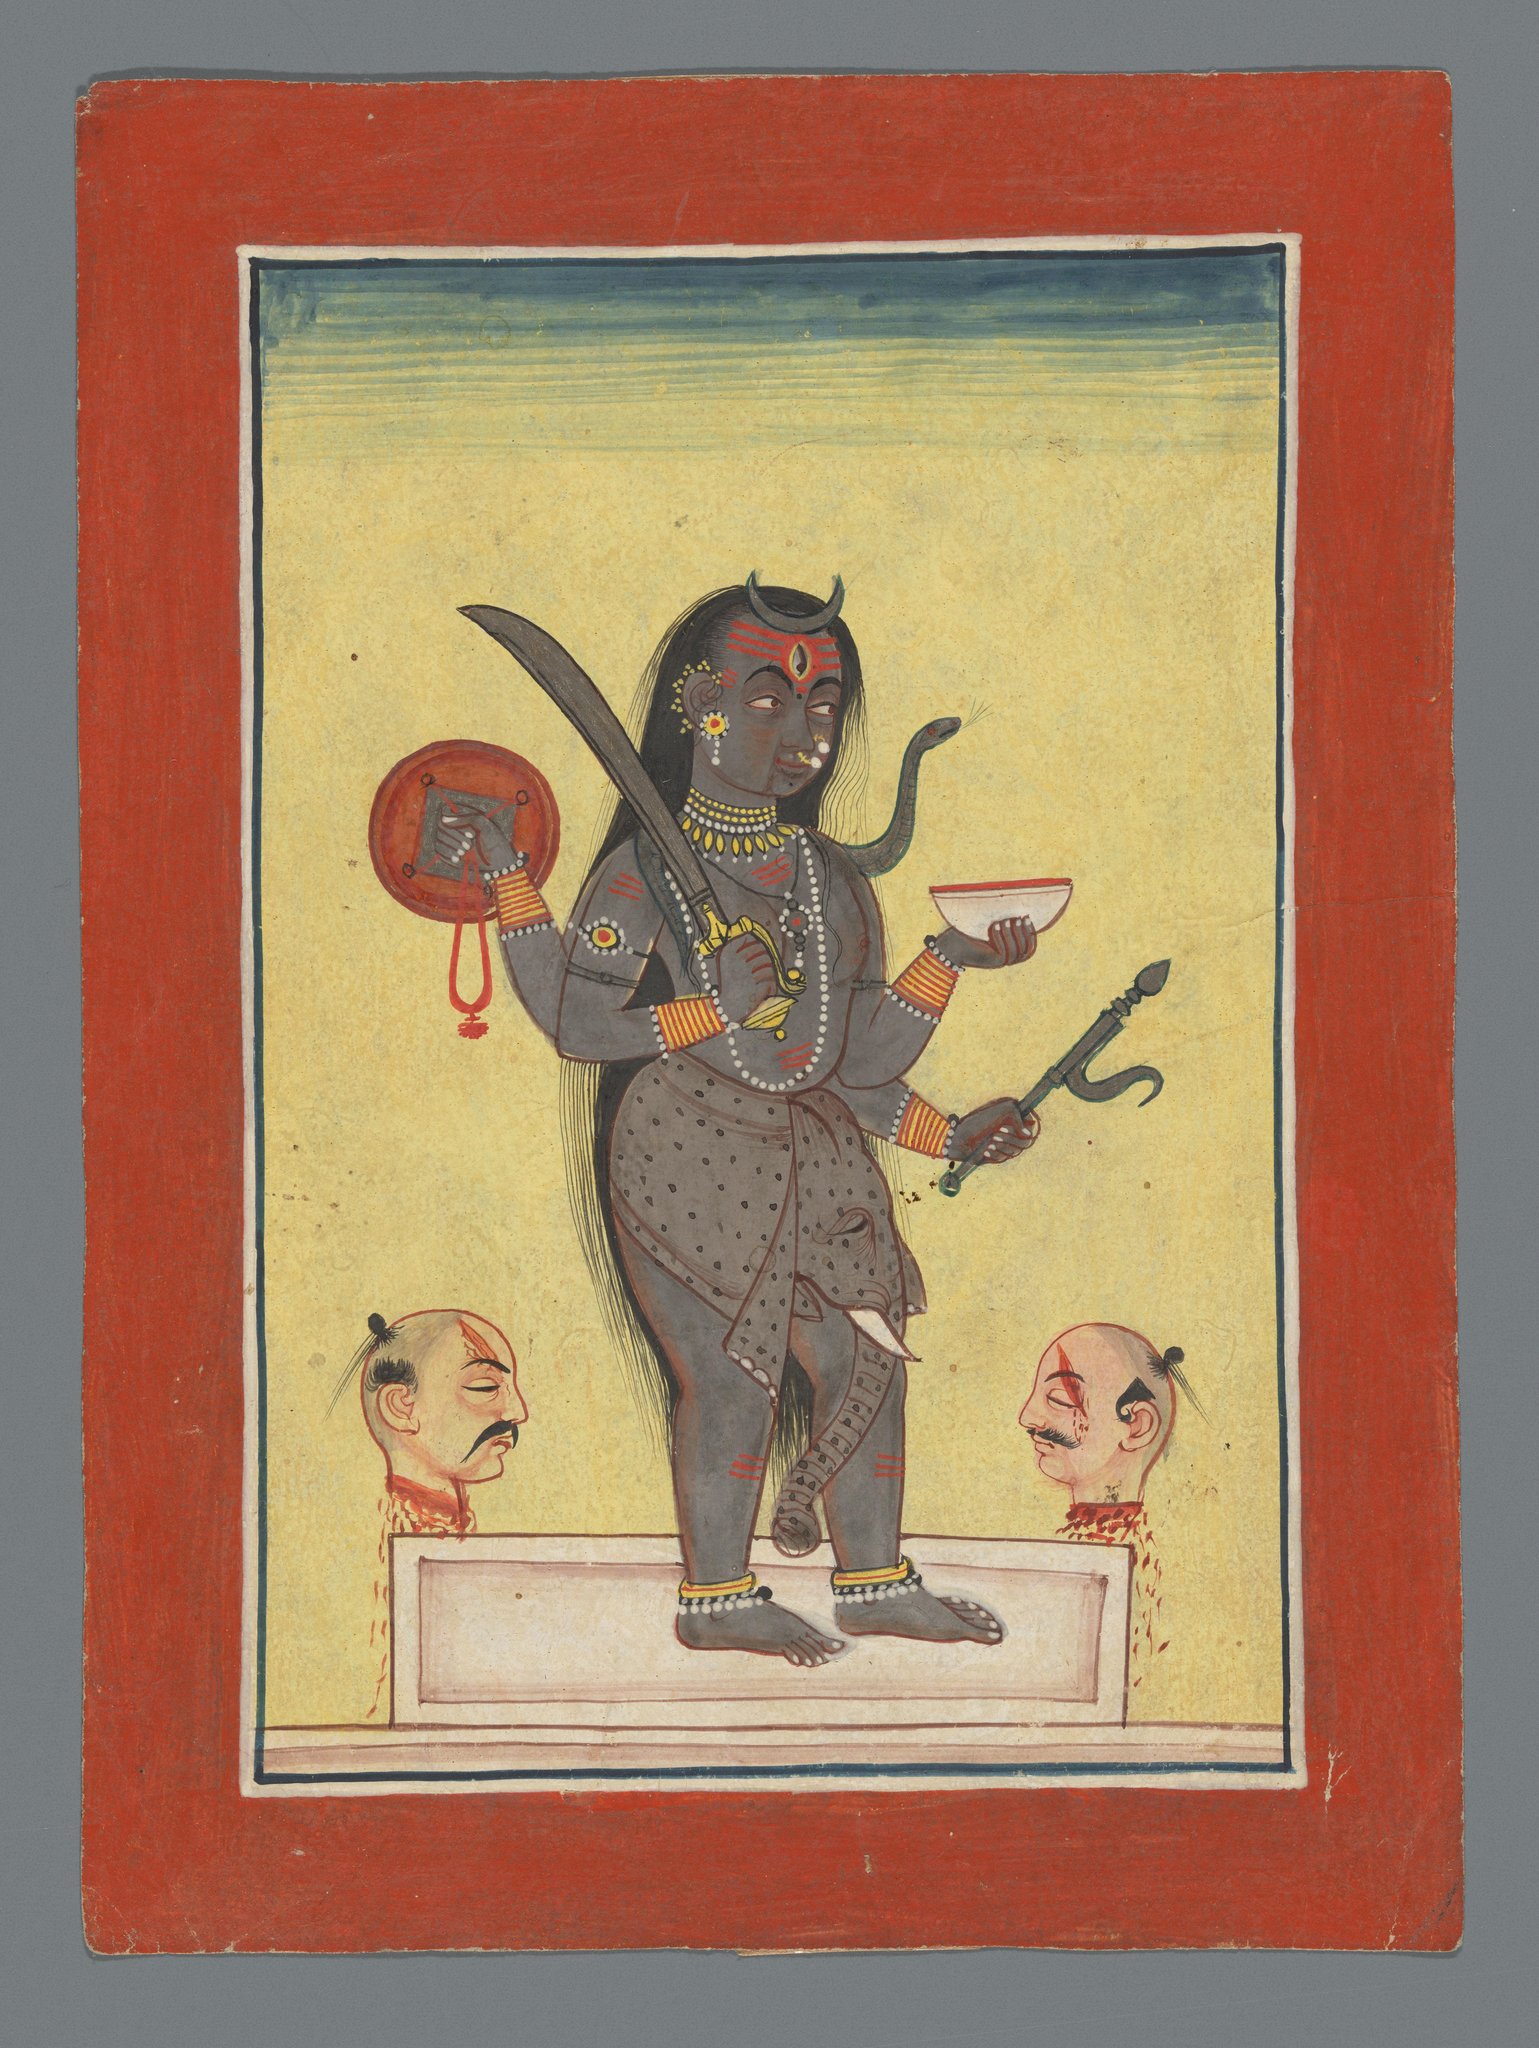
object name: indian miniature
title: Hindu deity from Mandi (Himachal Pradesh, North India)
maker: Anonymous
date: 1750-1799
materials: paper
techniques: brush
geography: india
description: Bhairava (fierce form of Siva) clad in an elephant skin and two severed heads Mandi Purchased from Maggs Bros. London 1972, Published in Oriental Miniatures & Illumination, Bulletin No. 20. March 1972, No.157